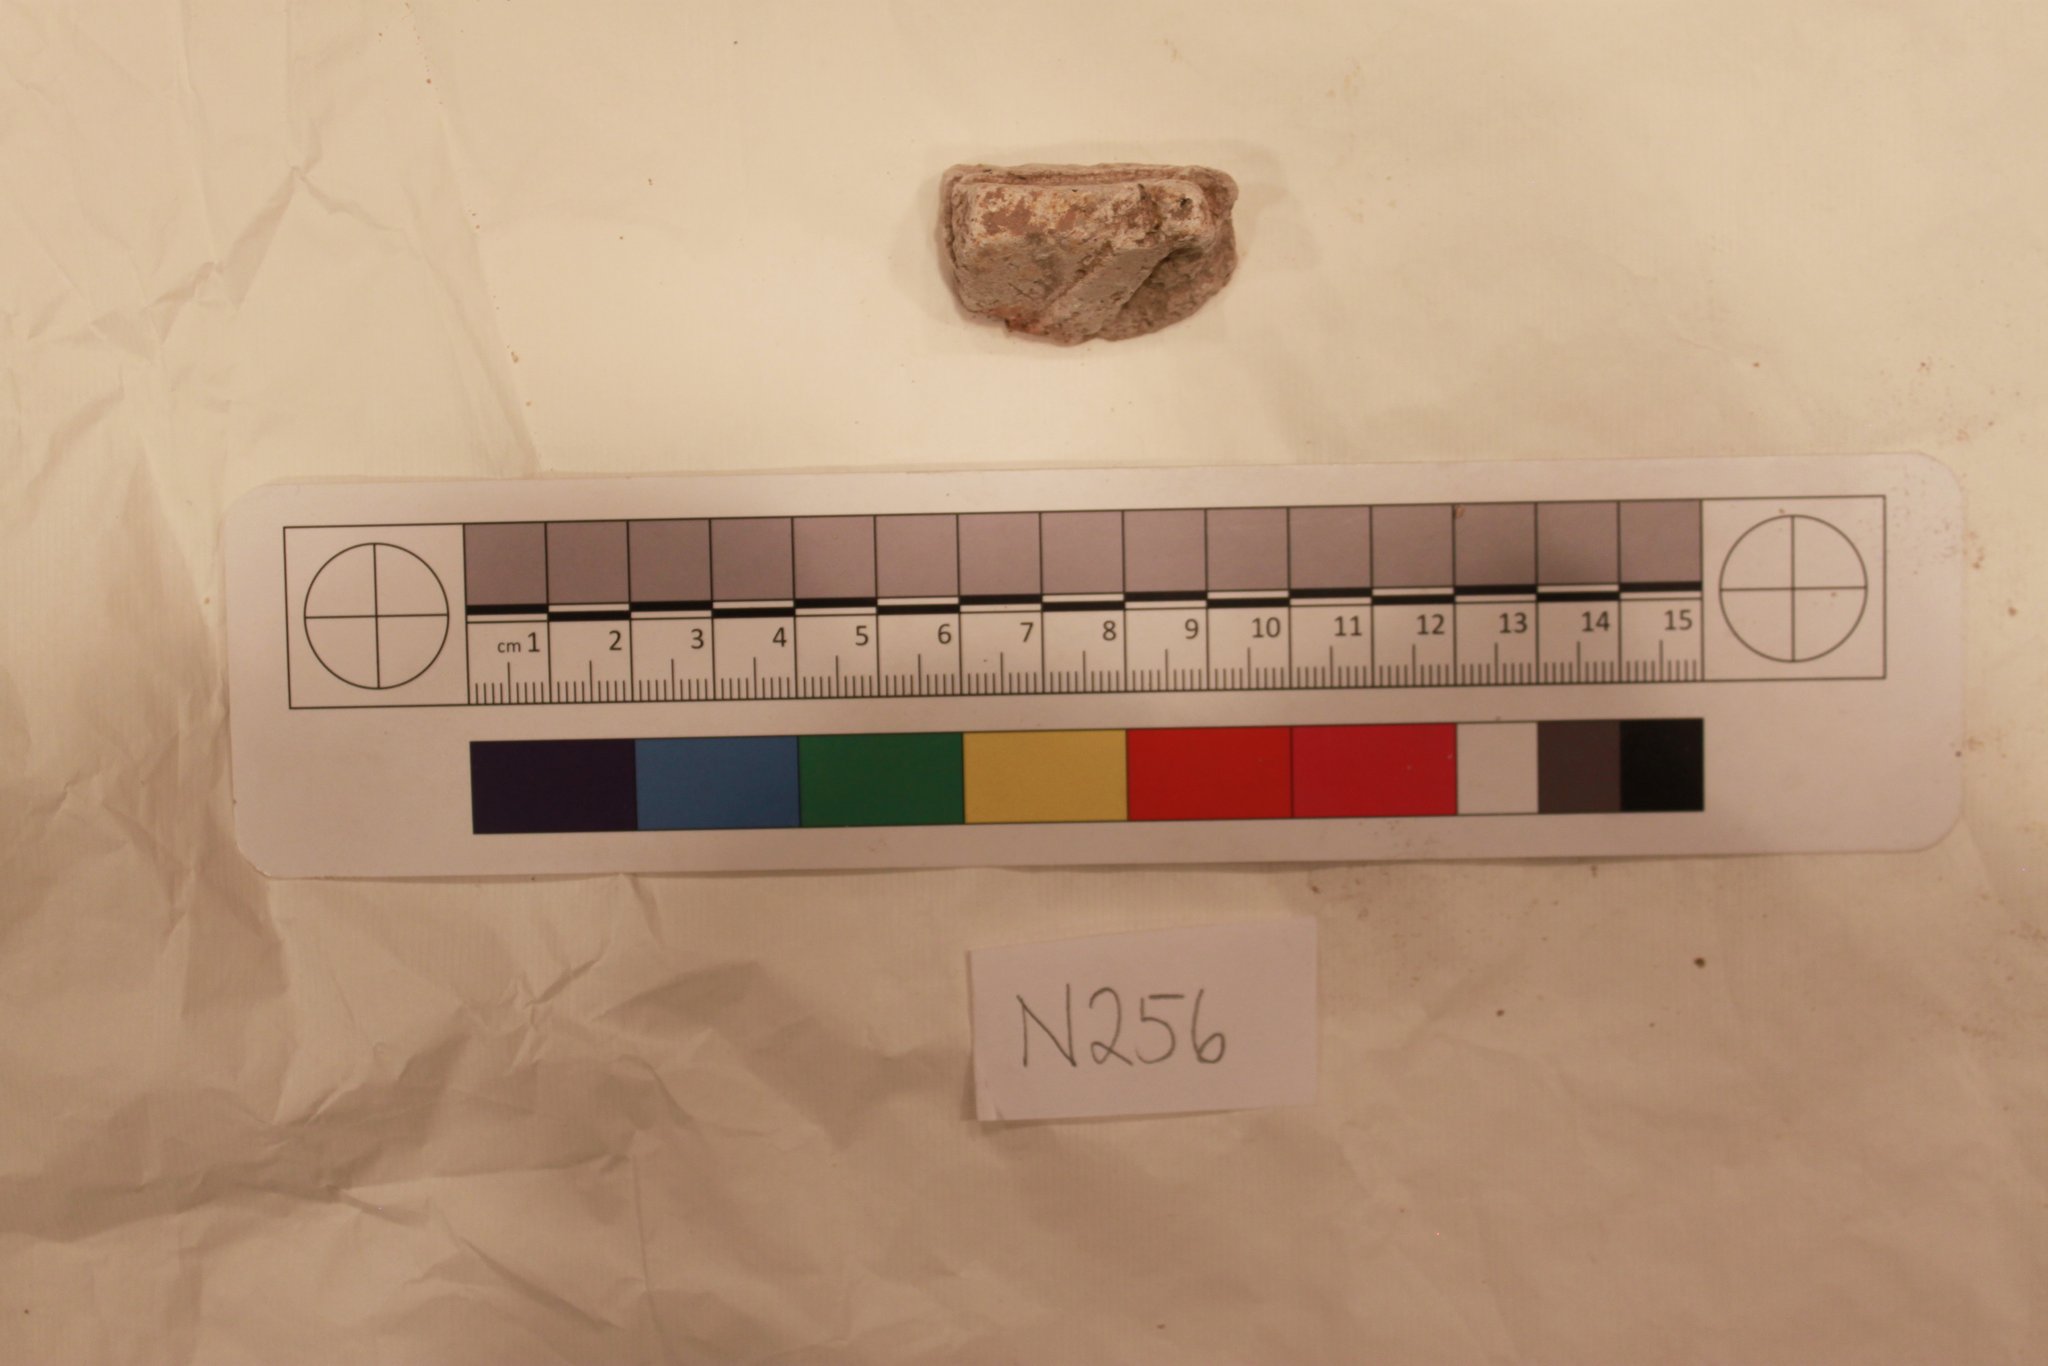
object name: fragment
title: Stucco Fragment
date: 701-1200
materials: plaster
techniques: carving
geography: iran